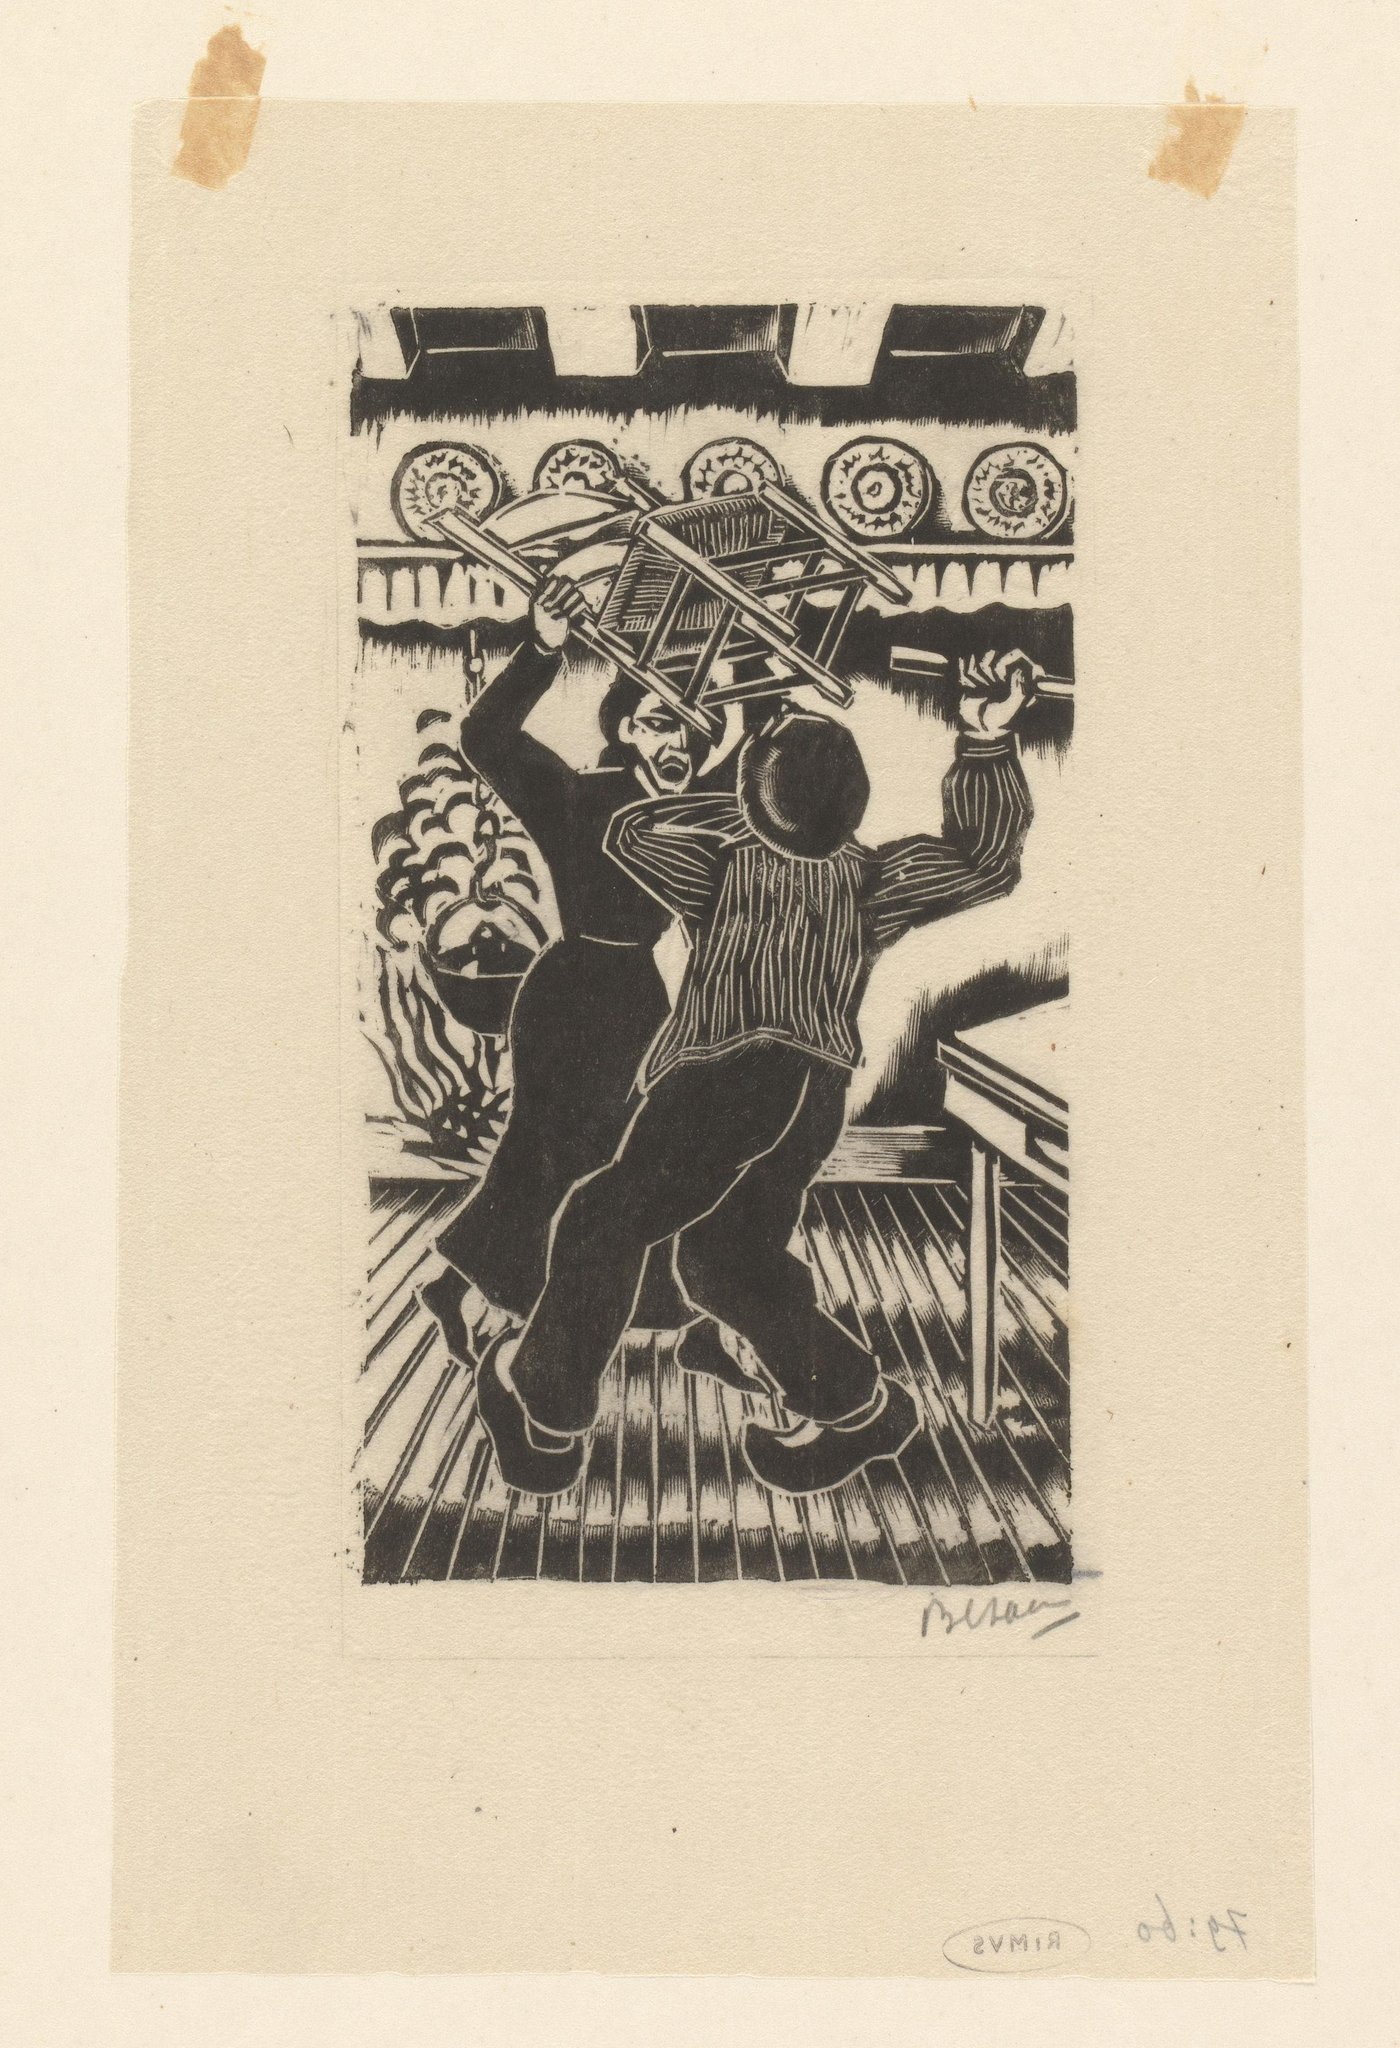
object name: print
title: En plotseling stootte ze met al haar kracht de pooten van den stoel vooruit, vlak in zijn walgelijk, paarsrood gezwollen gezicht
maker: jo bezaan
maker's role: draughtsman, print maker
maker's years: 1894-1952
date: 1942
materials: paper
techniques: woodcut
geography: amsterdam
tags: kitchen, fighting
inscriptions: collector's mark: Lugt 2228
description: Prent gebruikt voor: Buysse, Cyriel. Het leven van Rozeke van Dalen. Amsterdam: Contact-boekerij, 1942.